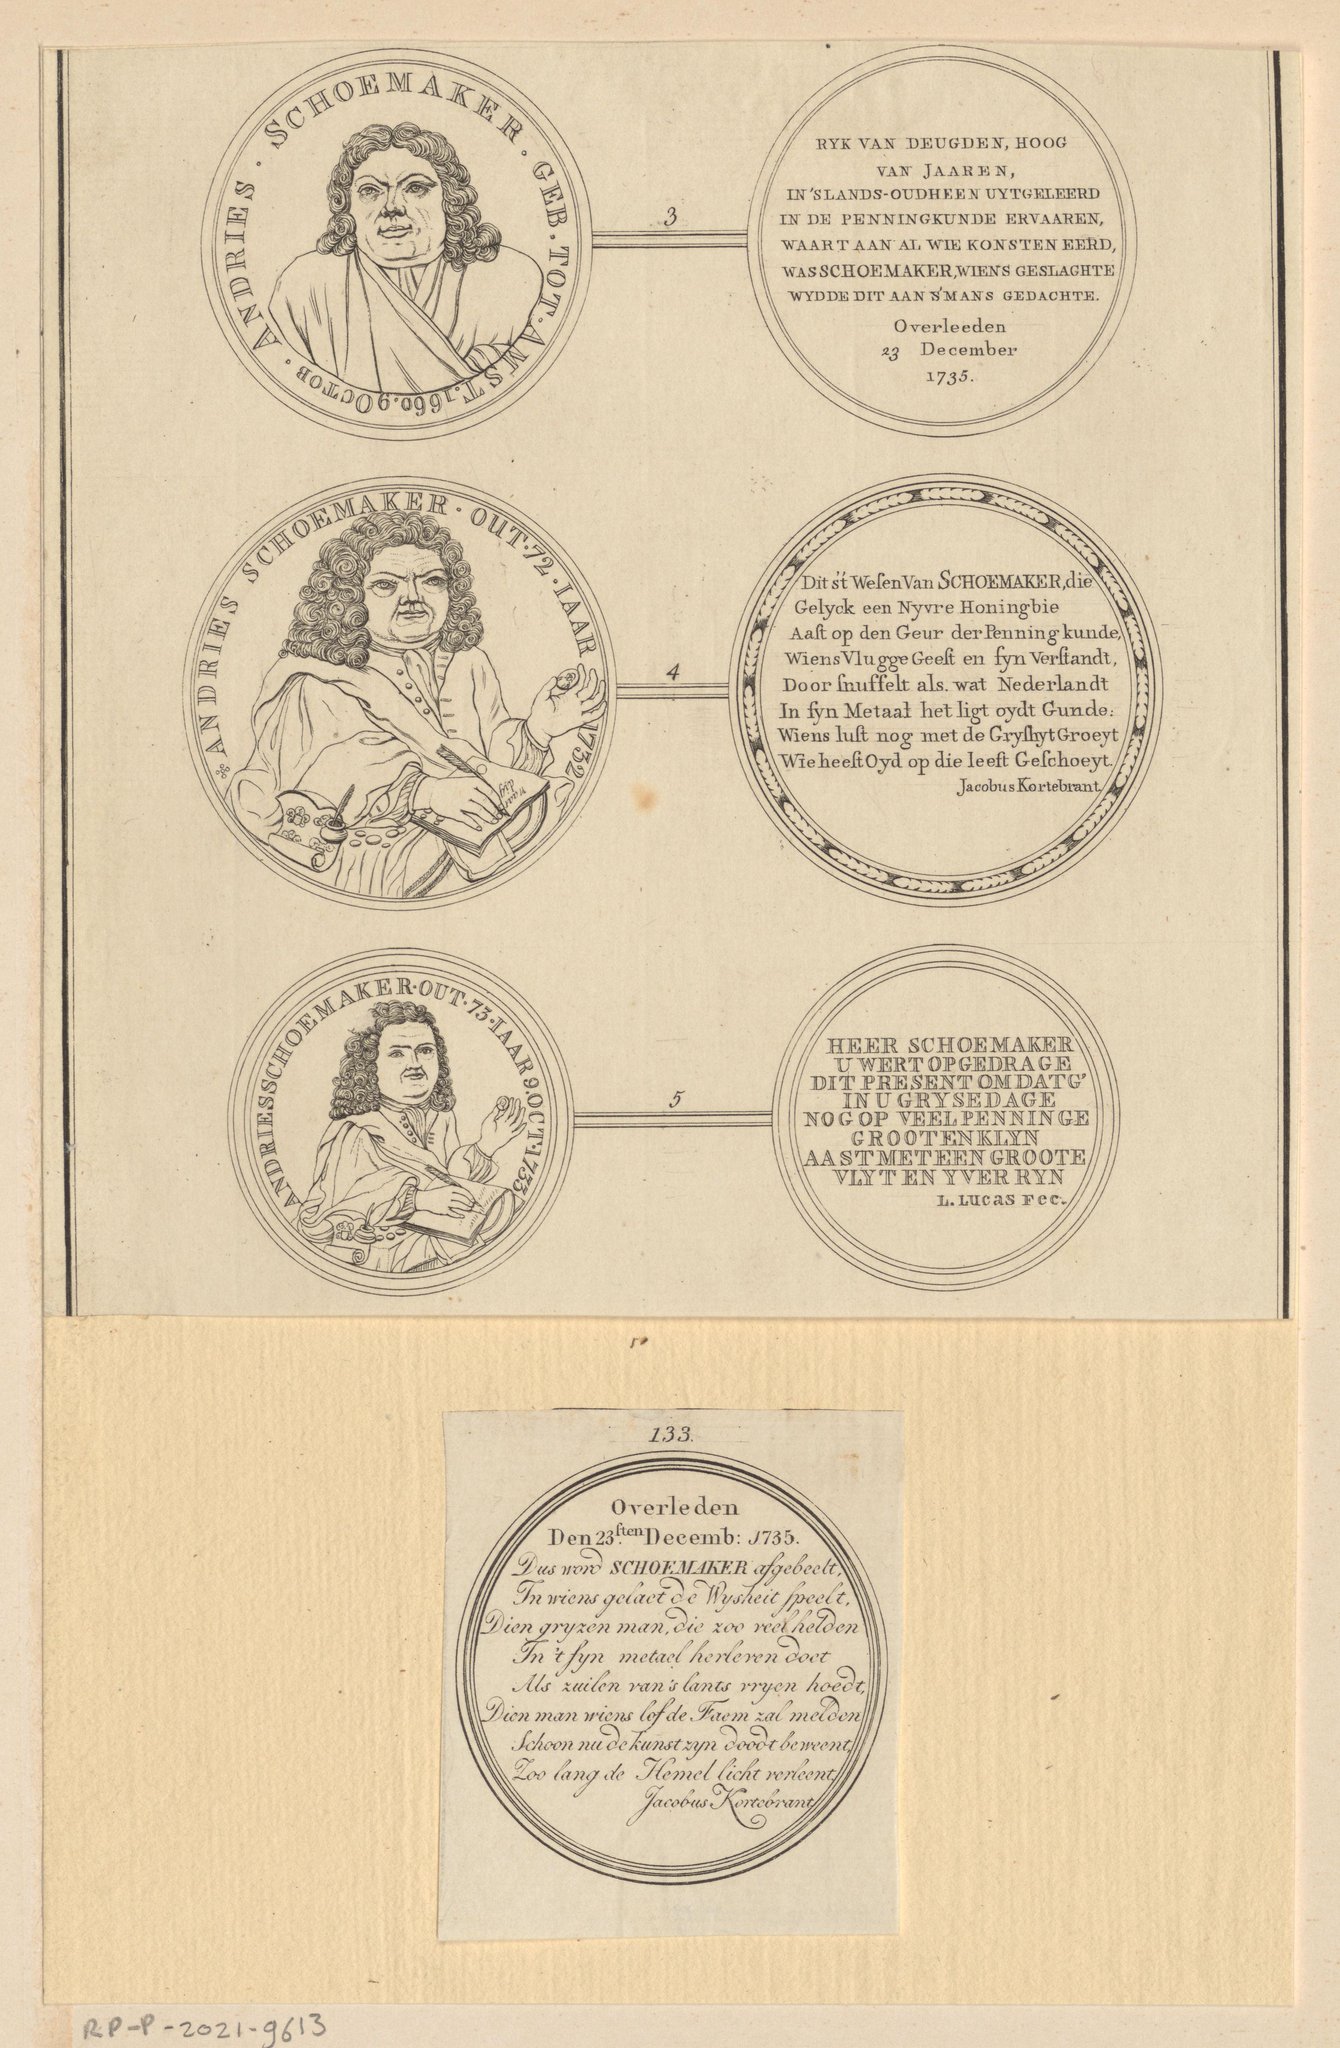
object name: print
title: Voor- en achterzijde van drie penningen met het portret van Andries Schoemaker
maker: Anonymous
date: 1820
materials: paper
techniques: engraving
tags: amsterdam, draughtsman, andries schoemaker, historical persons, medal (considered as a piece of sculpture, regardless of its specific function)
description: Prenten waarschijnlijk uit: Beschrijving van nederlandsche historie-penningen. 5 dln. Amsterdam: Koninklijk Nederlandsche Instituut van Wetenschappen, Letterkunde en Schoone Kunsten, 1821, pl. 1. Deze prent is samen met een ander blad uit dezelfde publicatie bevestigd op het opzetvel.